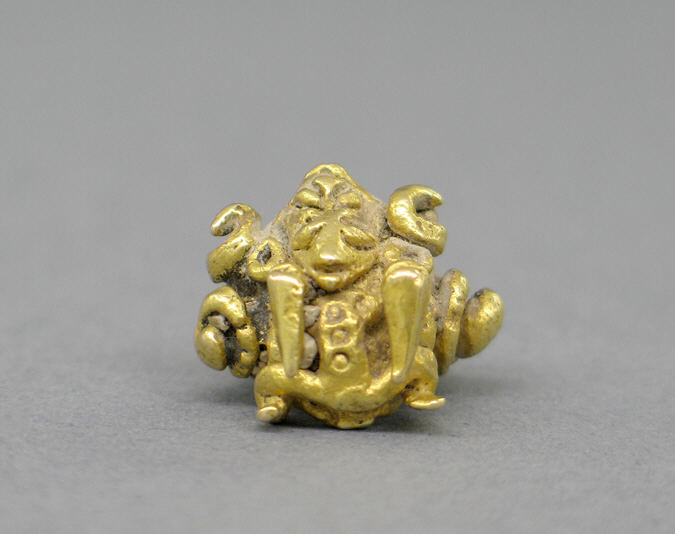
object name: ear ornament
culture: indonesian, javanese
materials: gold